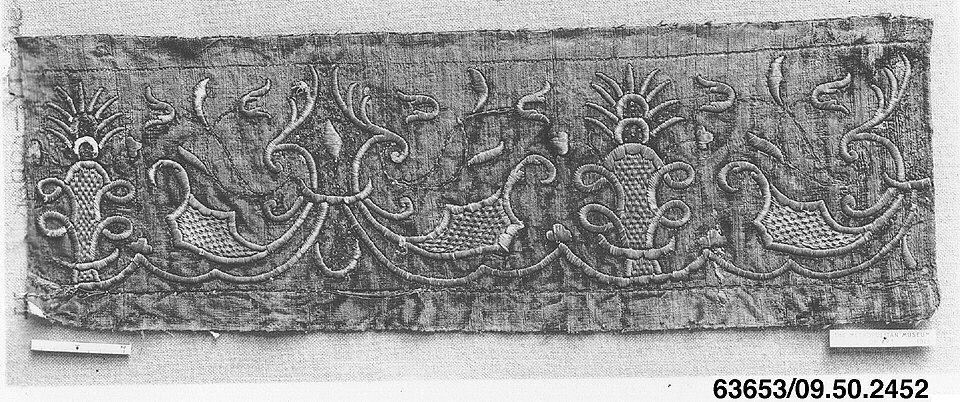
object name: band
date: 1601-1700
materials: metal thread, velvet